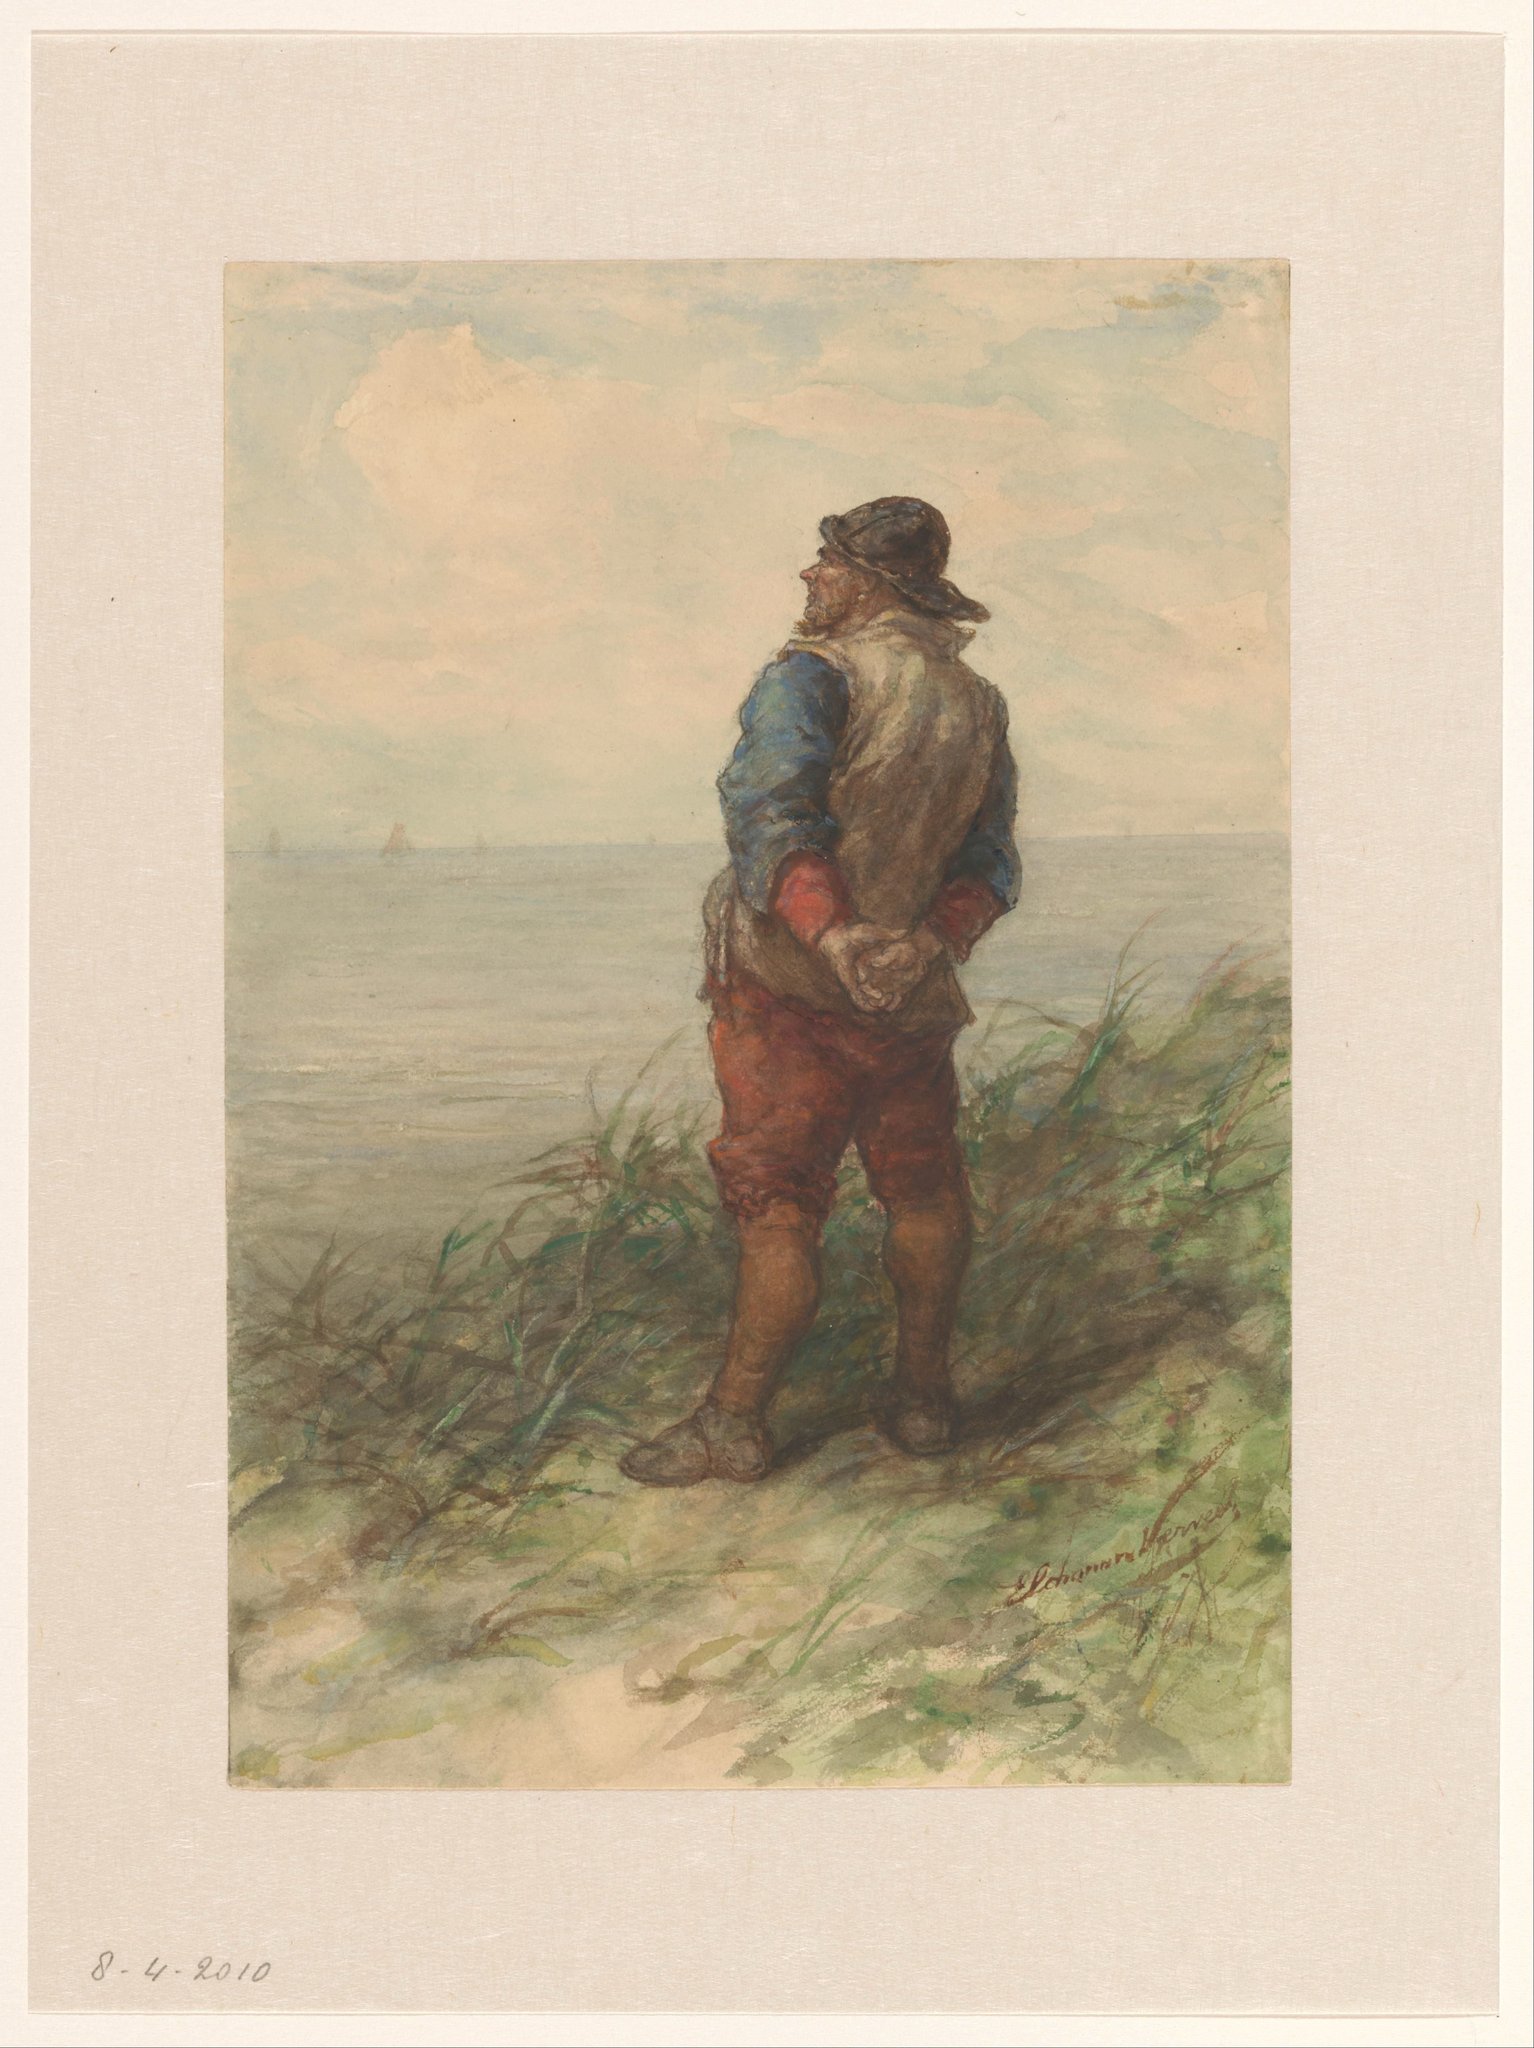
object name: watercolor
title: Zeeman vanaf de duinen uitkijkend over zee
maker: elchanon verveer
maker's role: draughtsman, print maker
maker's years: 1826-1900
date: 1836-1892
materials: chalk, paper, watercolor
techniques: brush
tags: dune coast, seaman